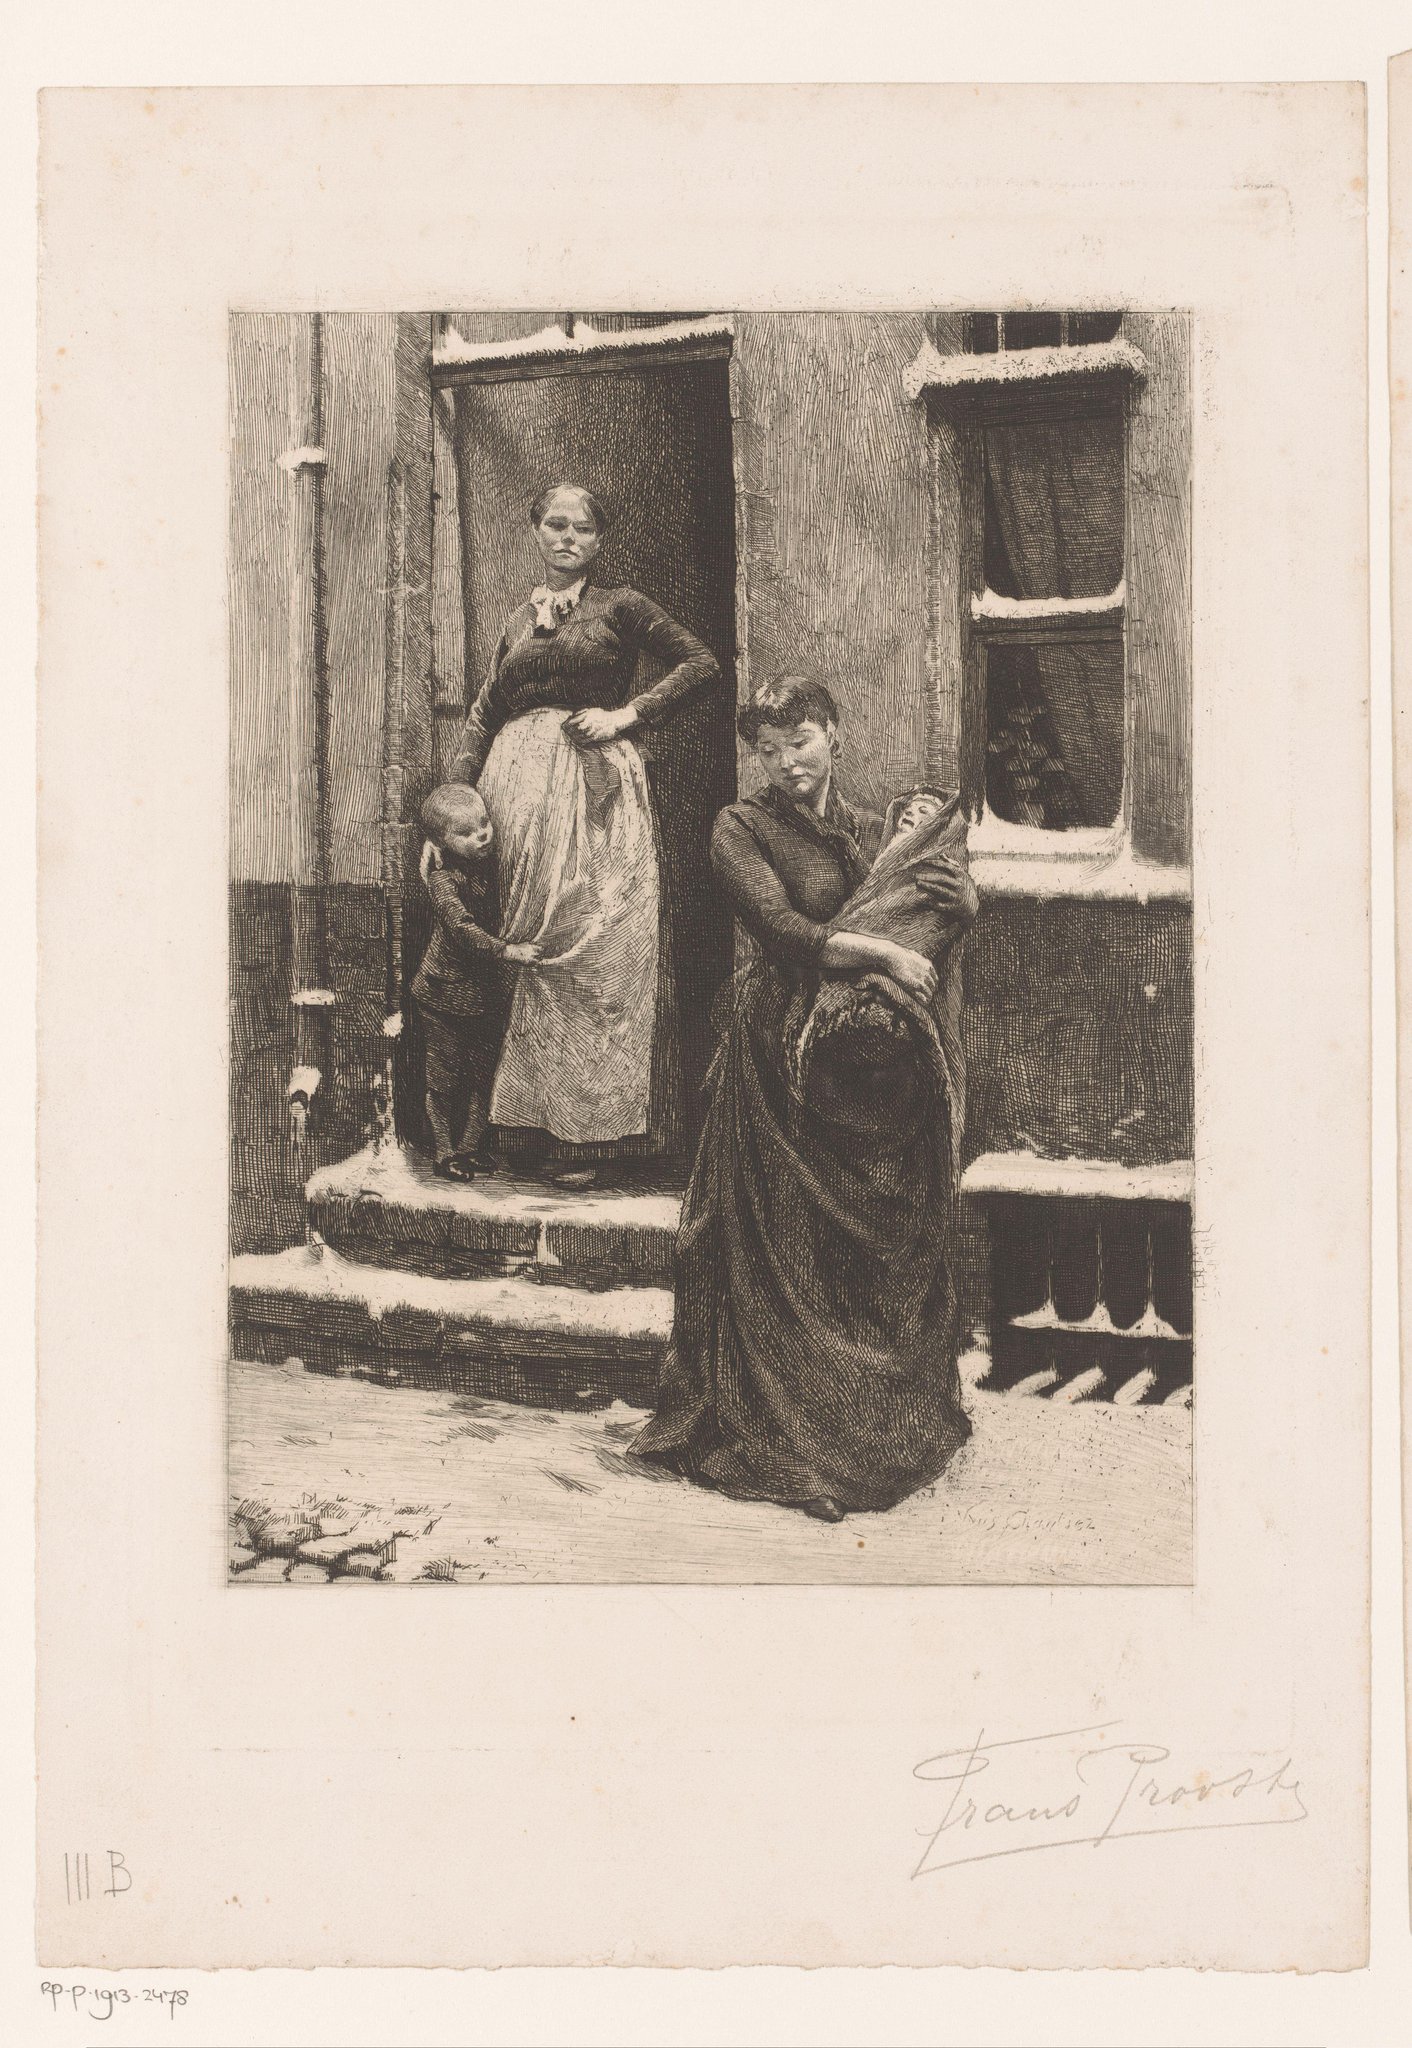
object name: print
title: Twee vrouwen met kinderen bij een deuropening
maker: frans proost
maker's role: painter, print maker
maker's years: 1875-1941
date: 1885-1913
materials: paper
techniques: drypoint, etching, intaglio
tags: open door, mother and baby or young child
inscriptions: collector's mark: Lugt 2228, annotation: ‘III B’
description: Illustratie bij de fabel 'De krekel en de mier'.